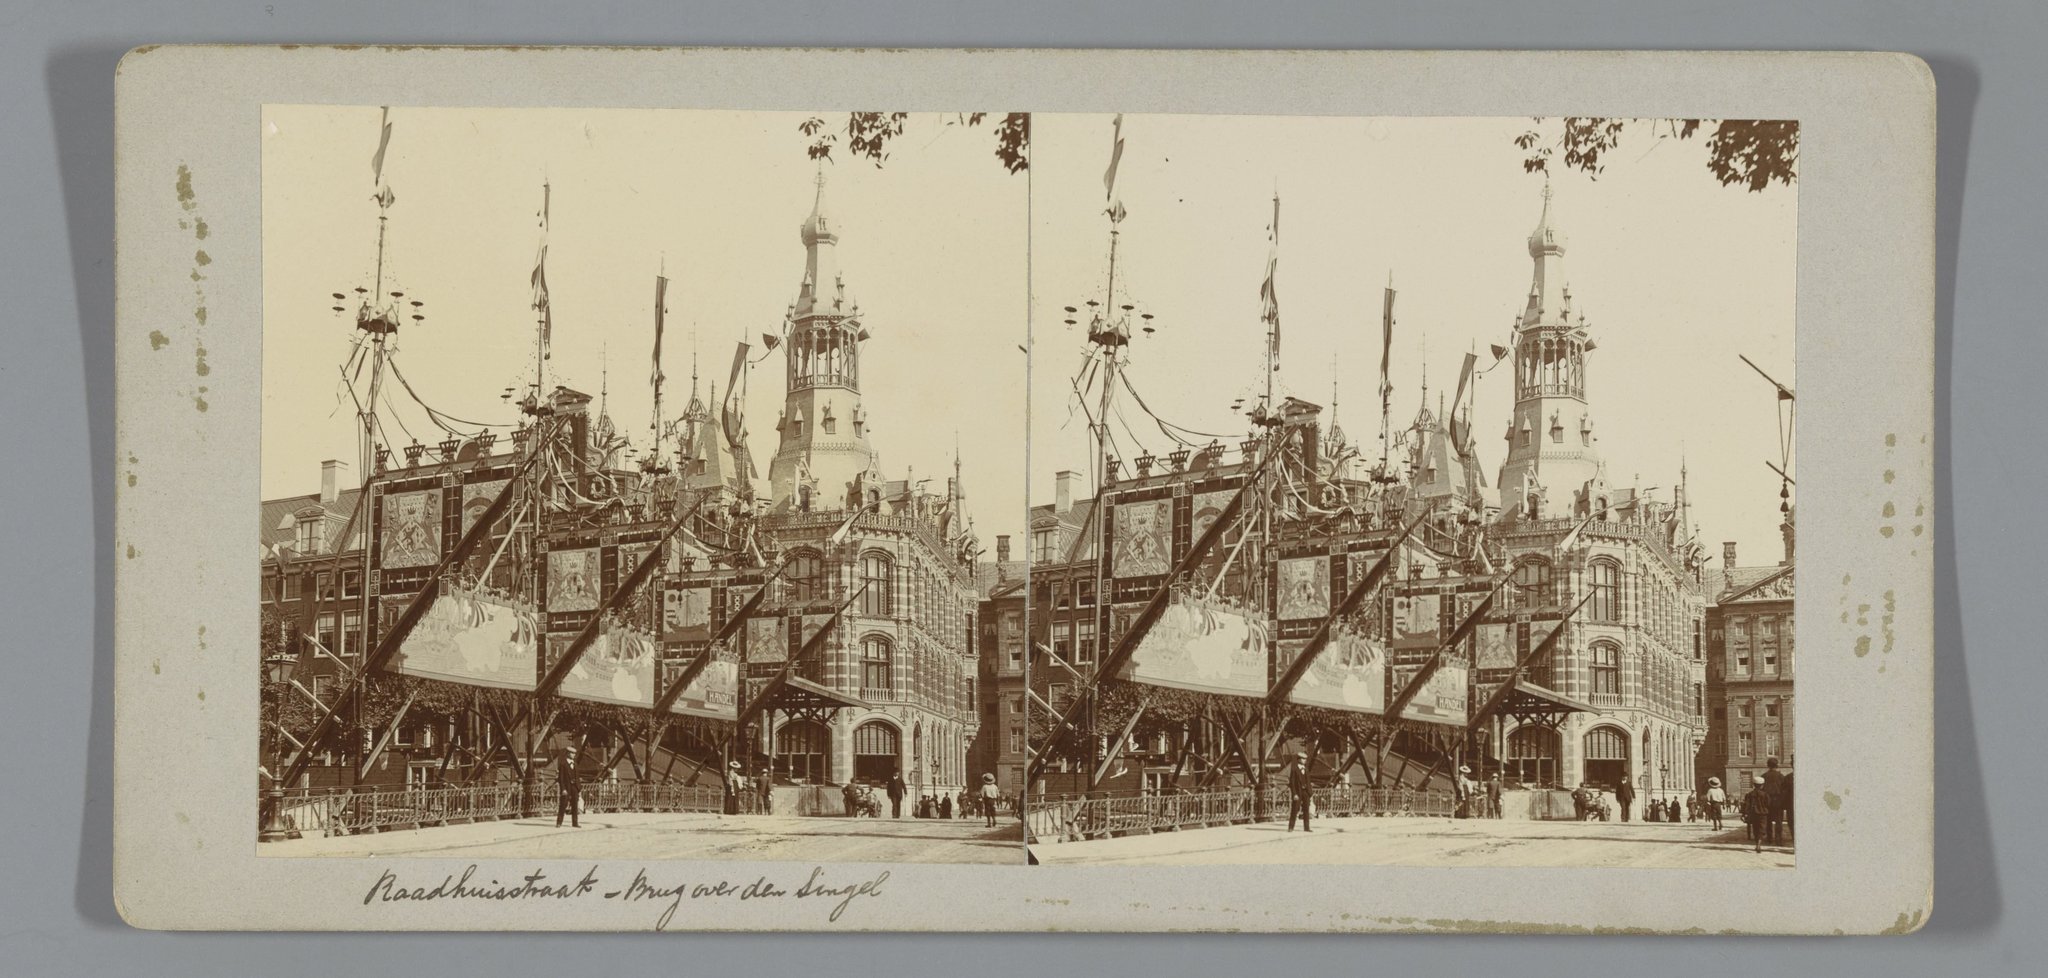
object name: stereograph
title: Raadhuisstraat - brug over den Singel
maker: Anonymous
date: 1898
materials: paper, cardboard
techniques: gelatin silver print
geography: amsterdam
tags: the hague, print maker, wilhelmina of the netherlands, bridge in city across river, canal, etc. - ii - ideal city, amsterdam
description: Brug 8, tot 5 juli 2016 de Huiszittenbrug genoemd. In de verte het Hoofdpostkantoor en het Koninklijk Paleis Amsterdam